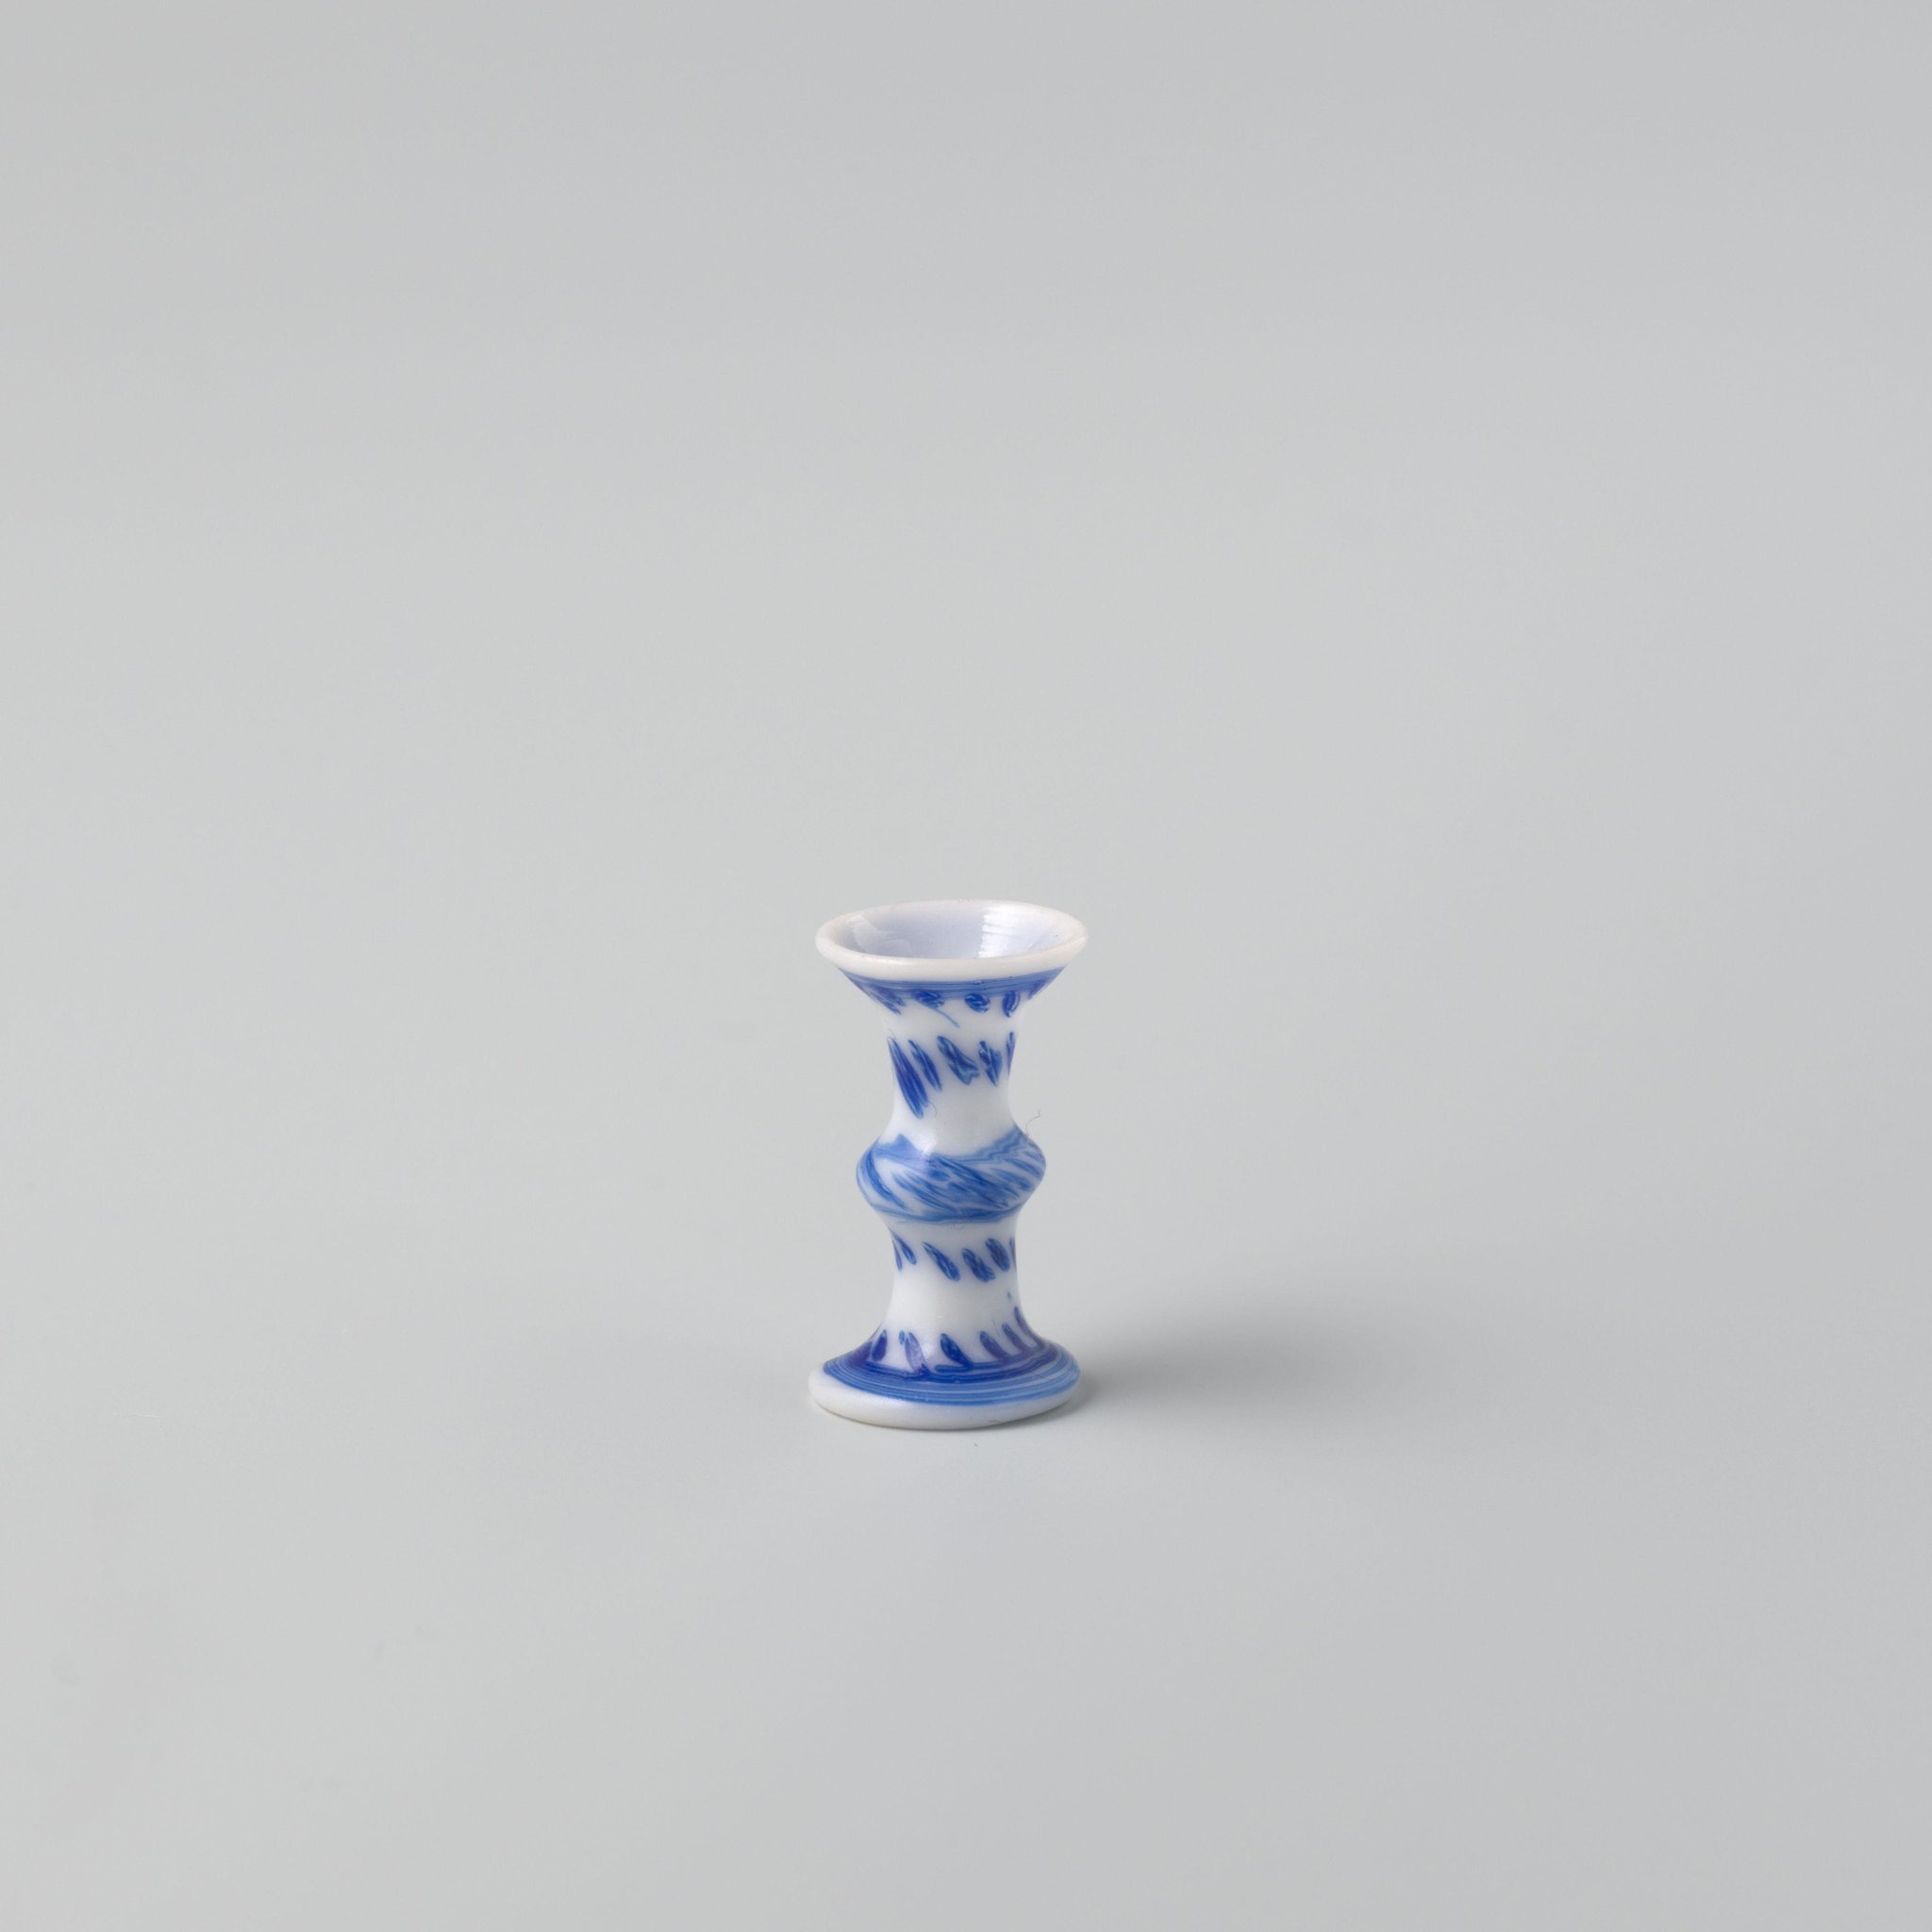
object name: cup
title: Vaas of beker van melkglas met blauwe emailverf beschildering, imitatie Chinees porselein; model met breed uitlopende voet en monding en verdikking in het midden, gestreept.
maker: Anonymous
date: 1675-1710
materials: glass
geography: amsterdam